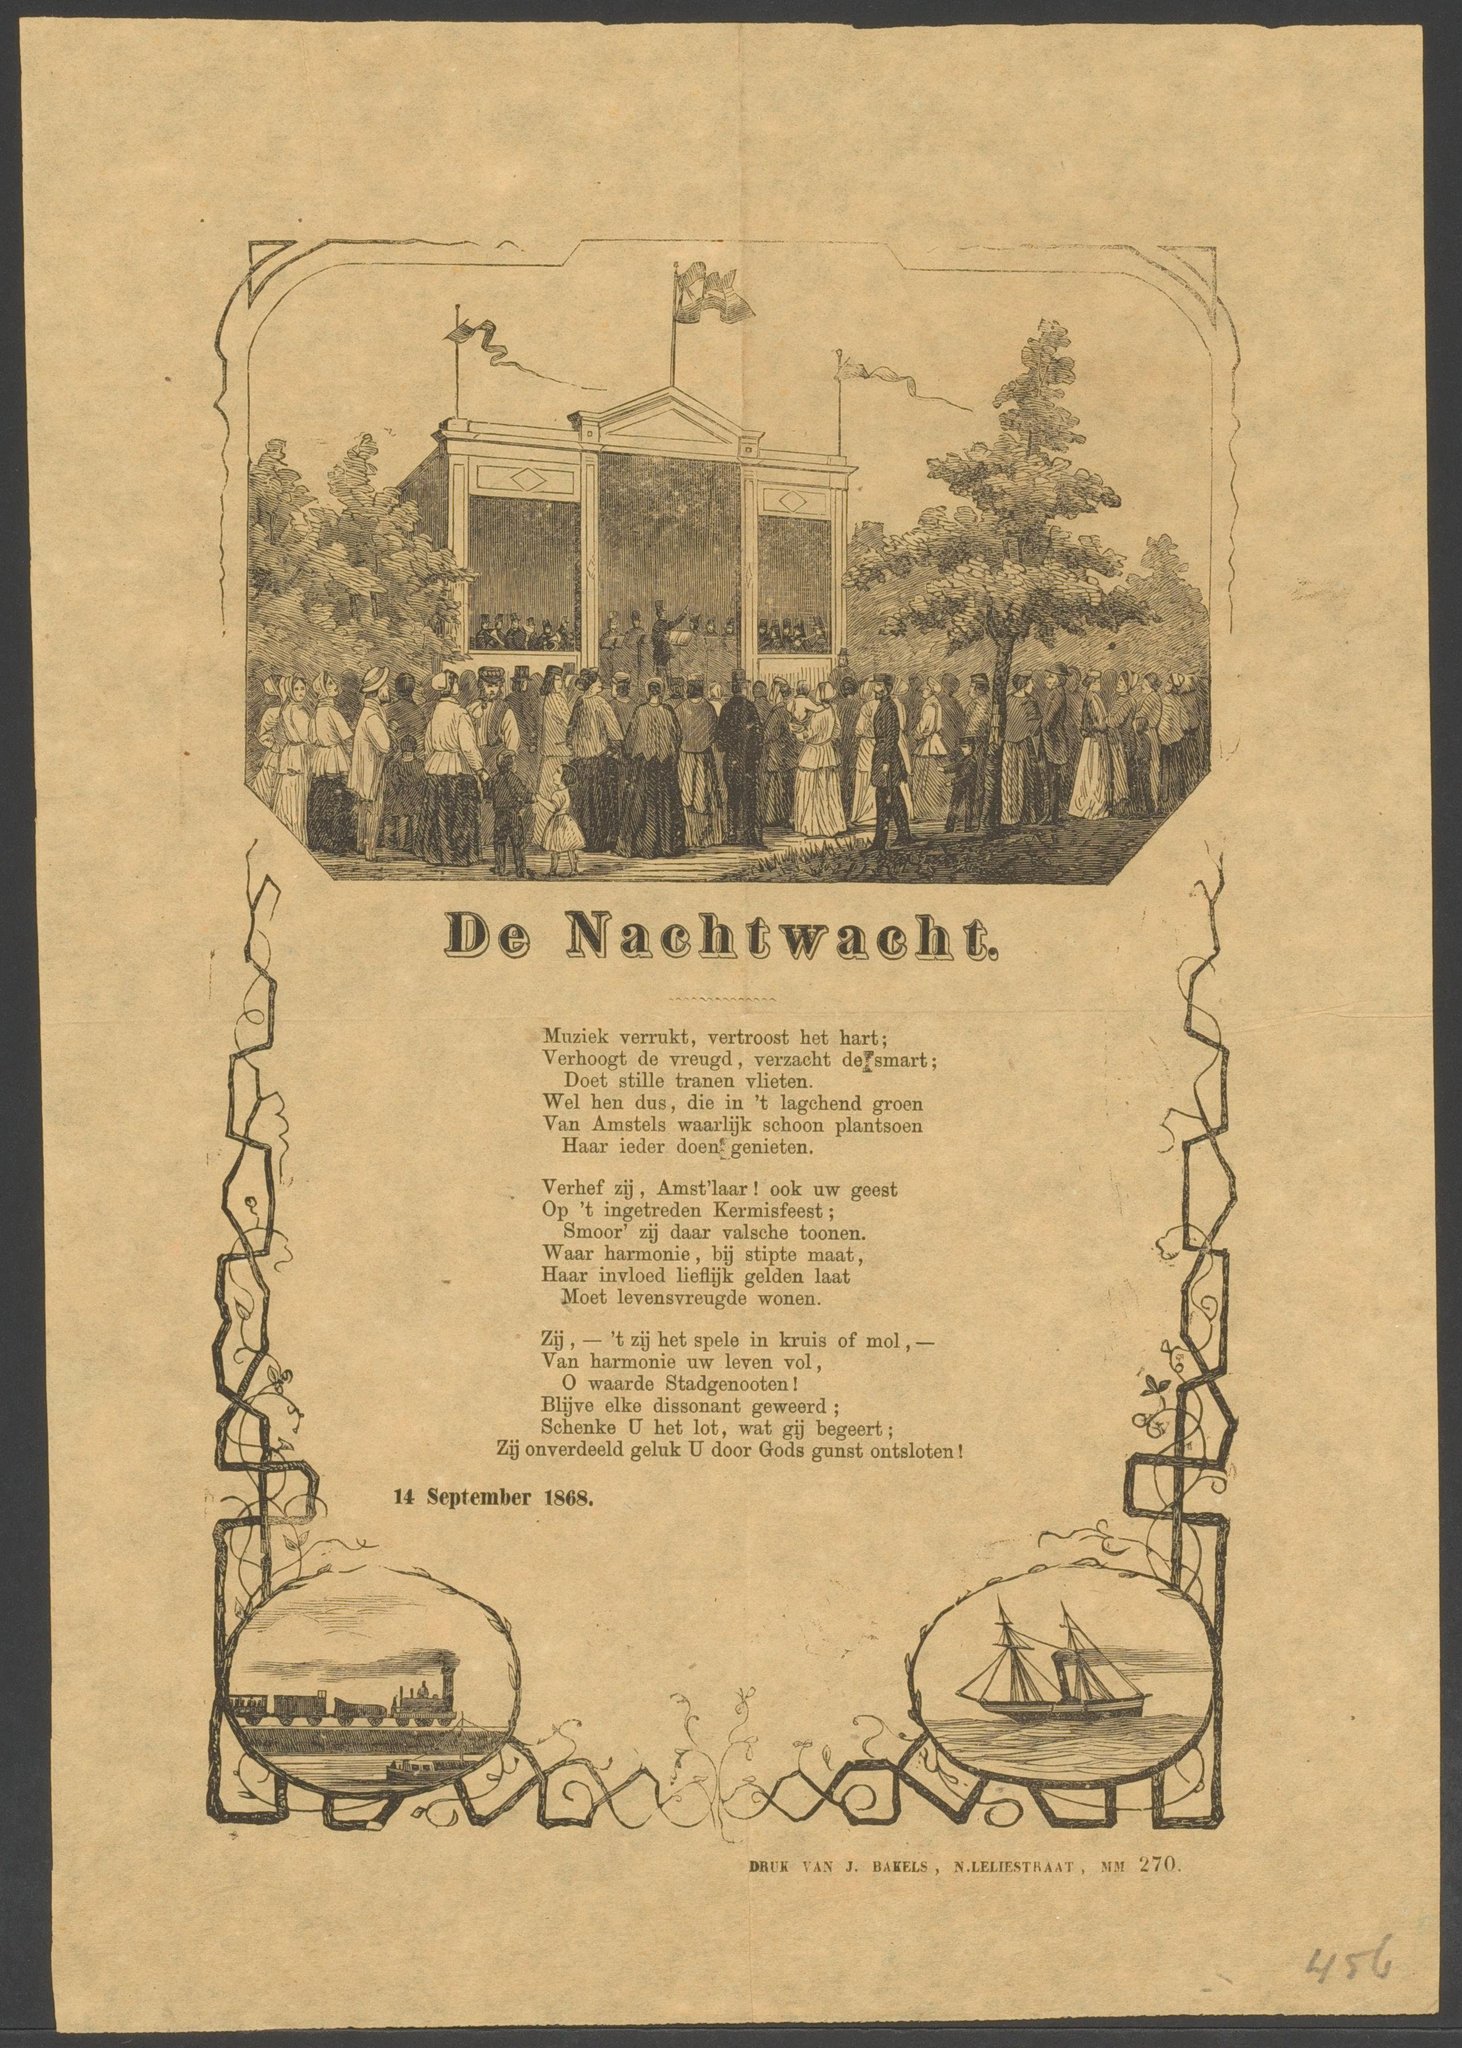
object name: fair print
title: De nachtwacht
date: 1868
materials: paper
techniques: letterpress printing, engraving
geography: amsterdam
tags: night patrol, pleasure fair and circus, amsterdam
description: Kermisprent van de Amsterdamse nachtwacht (ratelwacht), 14 september 1868. Onderwerpsrubrieken binnen de Atlas Zeden en Gewoonten: Zeden en gewoonten in engeren zin, Volksleven, Volksbladen, Nieuwjaars- en Kerstwenschen, Amsterdam.